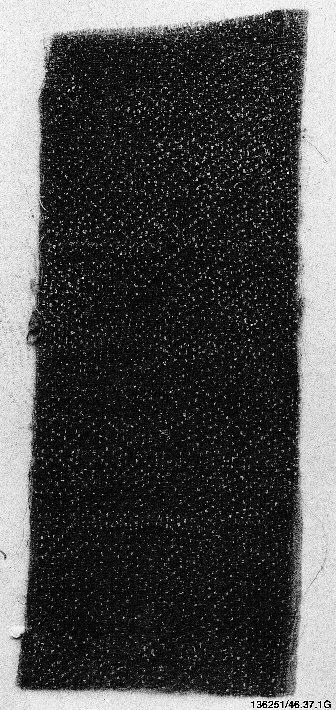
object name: turban fragment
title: Fragment of Turban Cloth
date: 1701-1800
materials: cotton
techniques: printing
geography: bangladesh